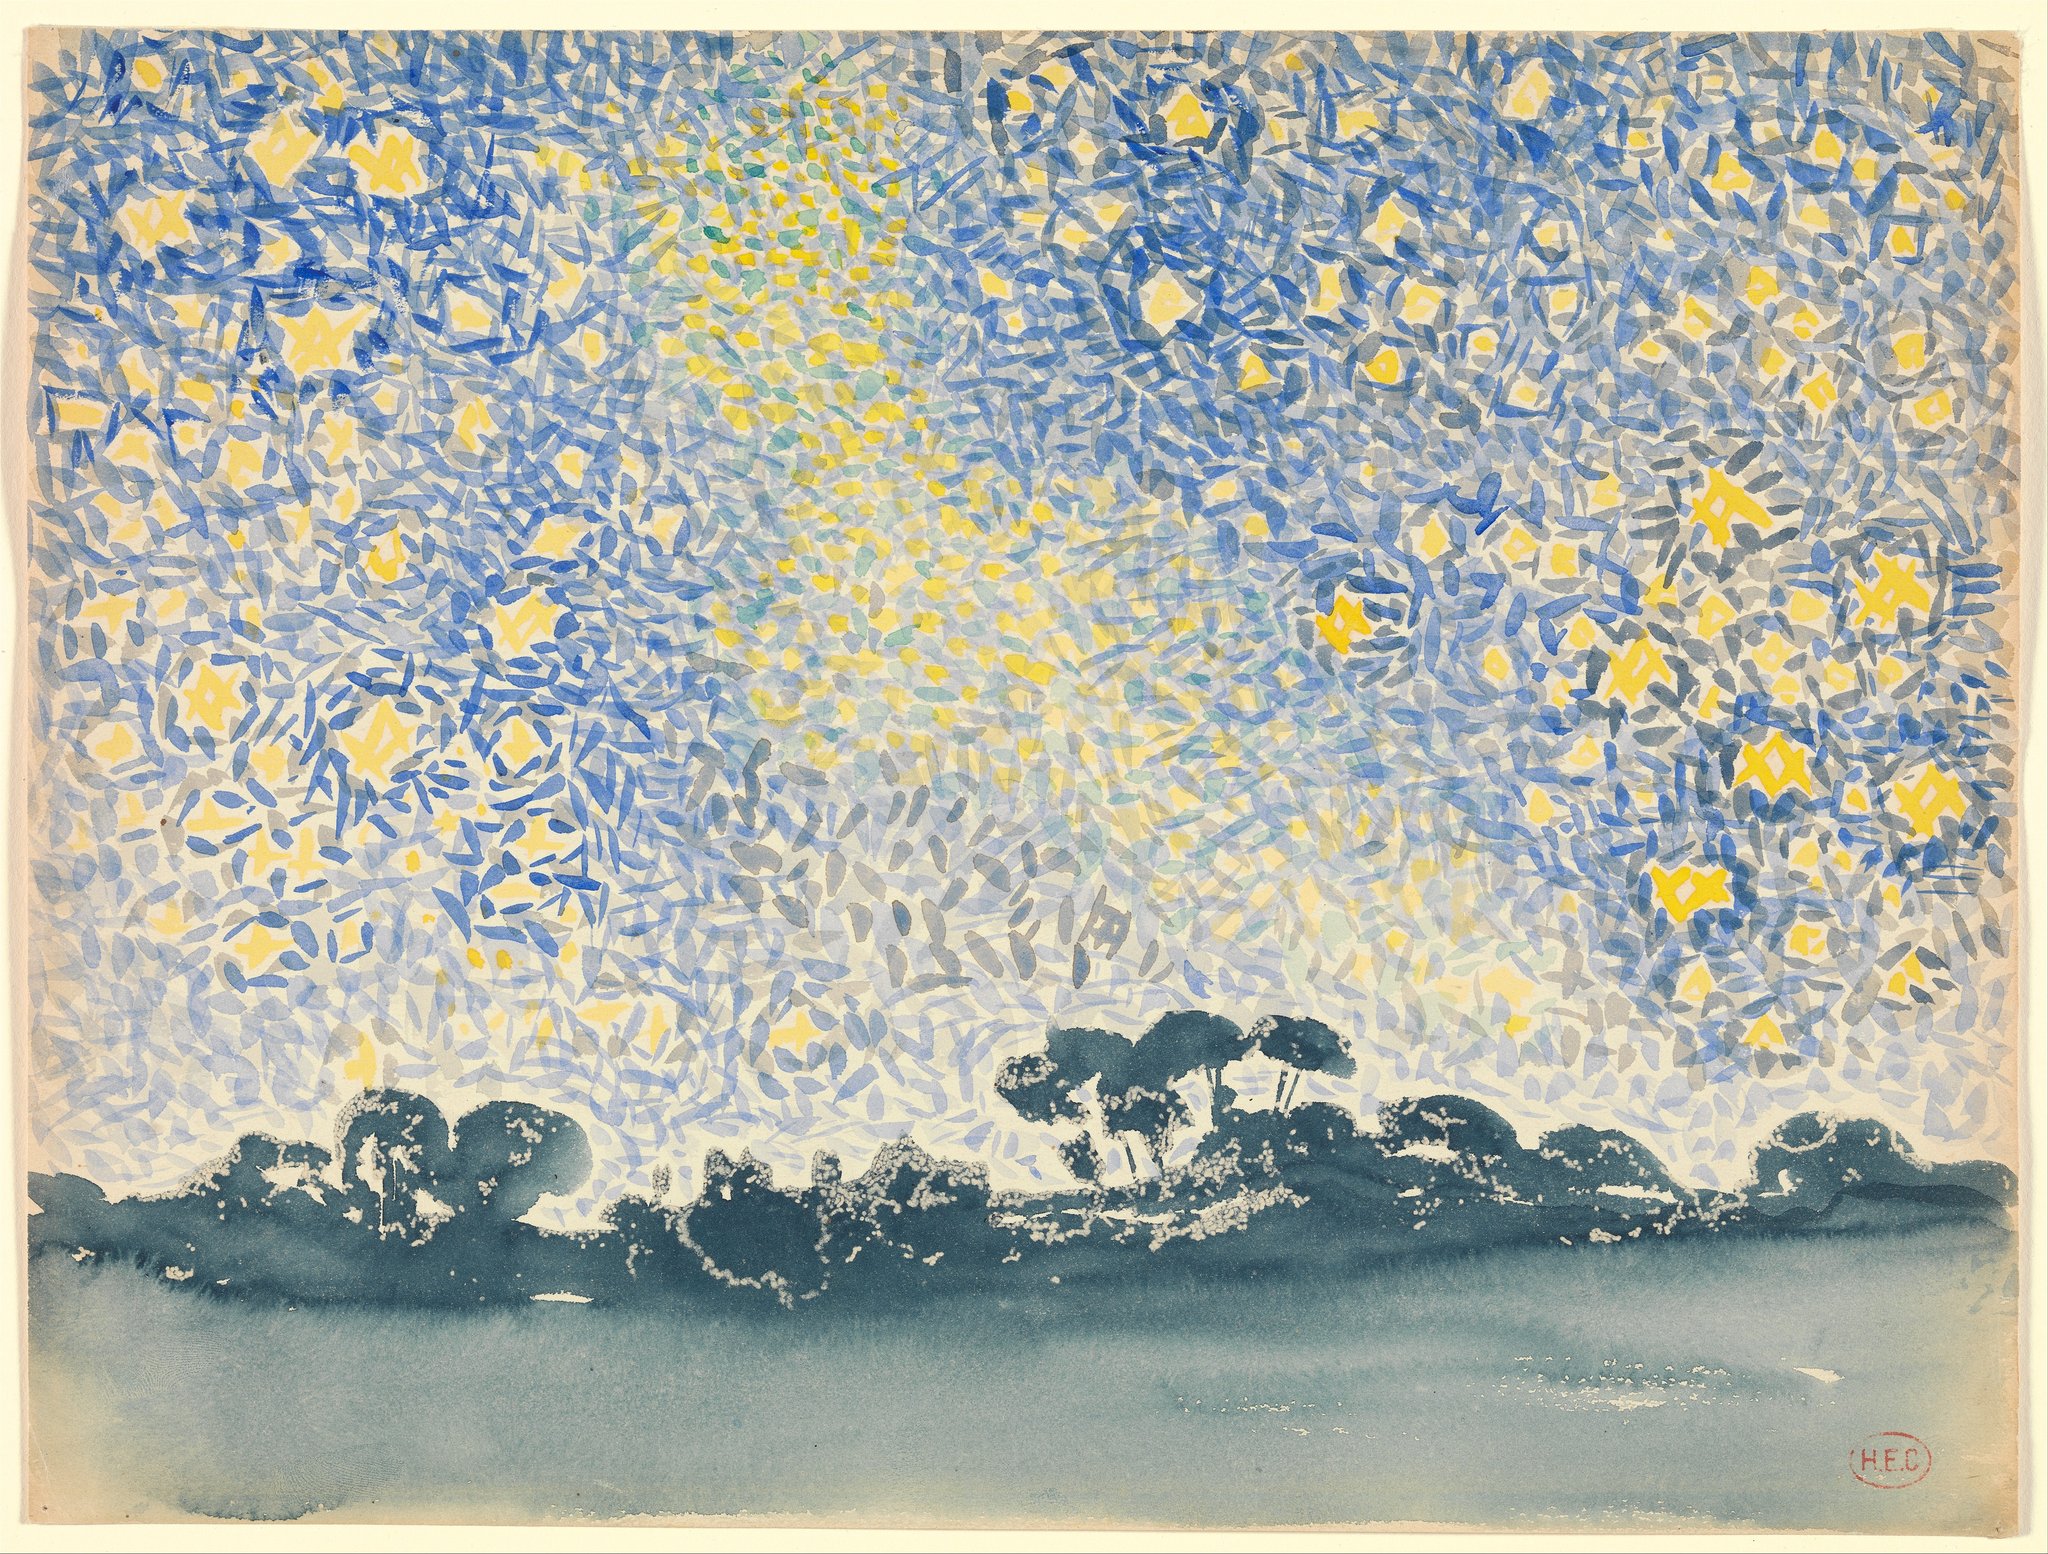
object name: drawing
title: Landscape with Stars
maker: henri-edmond cross (henri-edmond delacroix)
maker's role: artist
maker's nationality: french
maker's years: 1856-1910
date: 1905-1908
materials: watercolor, paper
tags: stars,landscapes